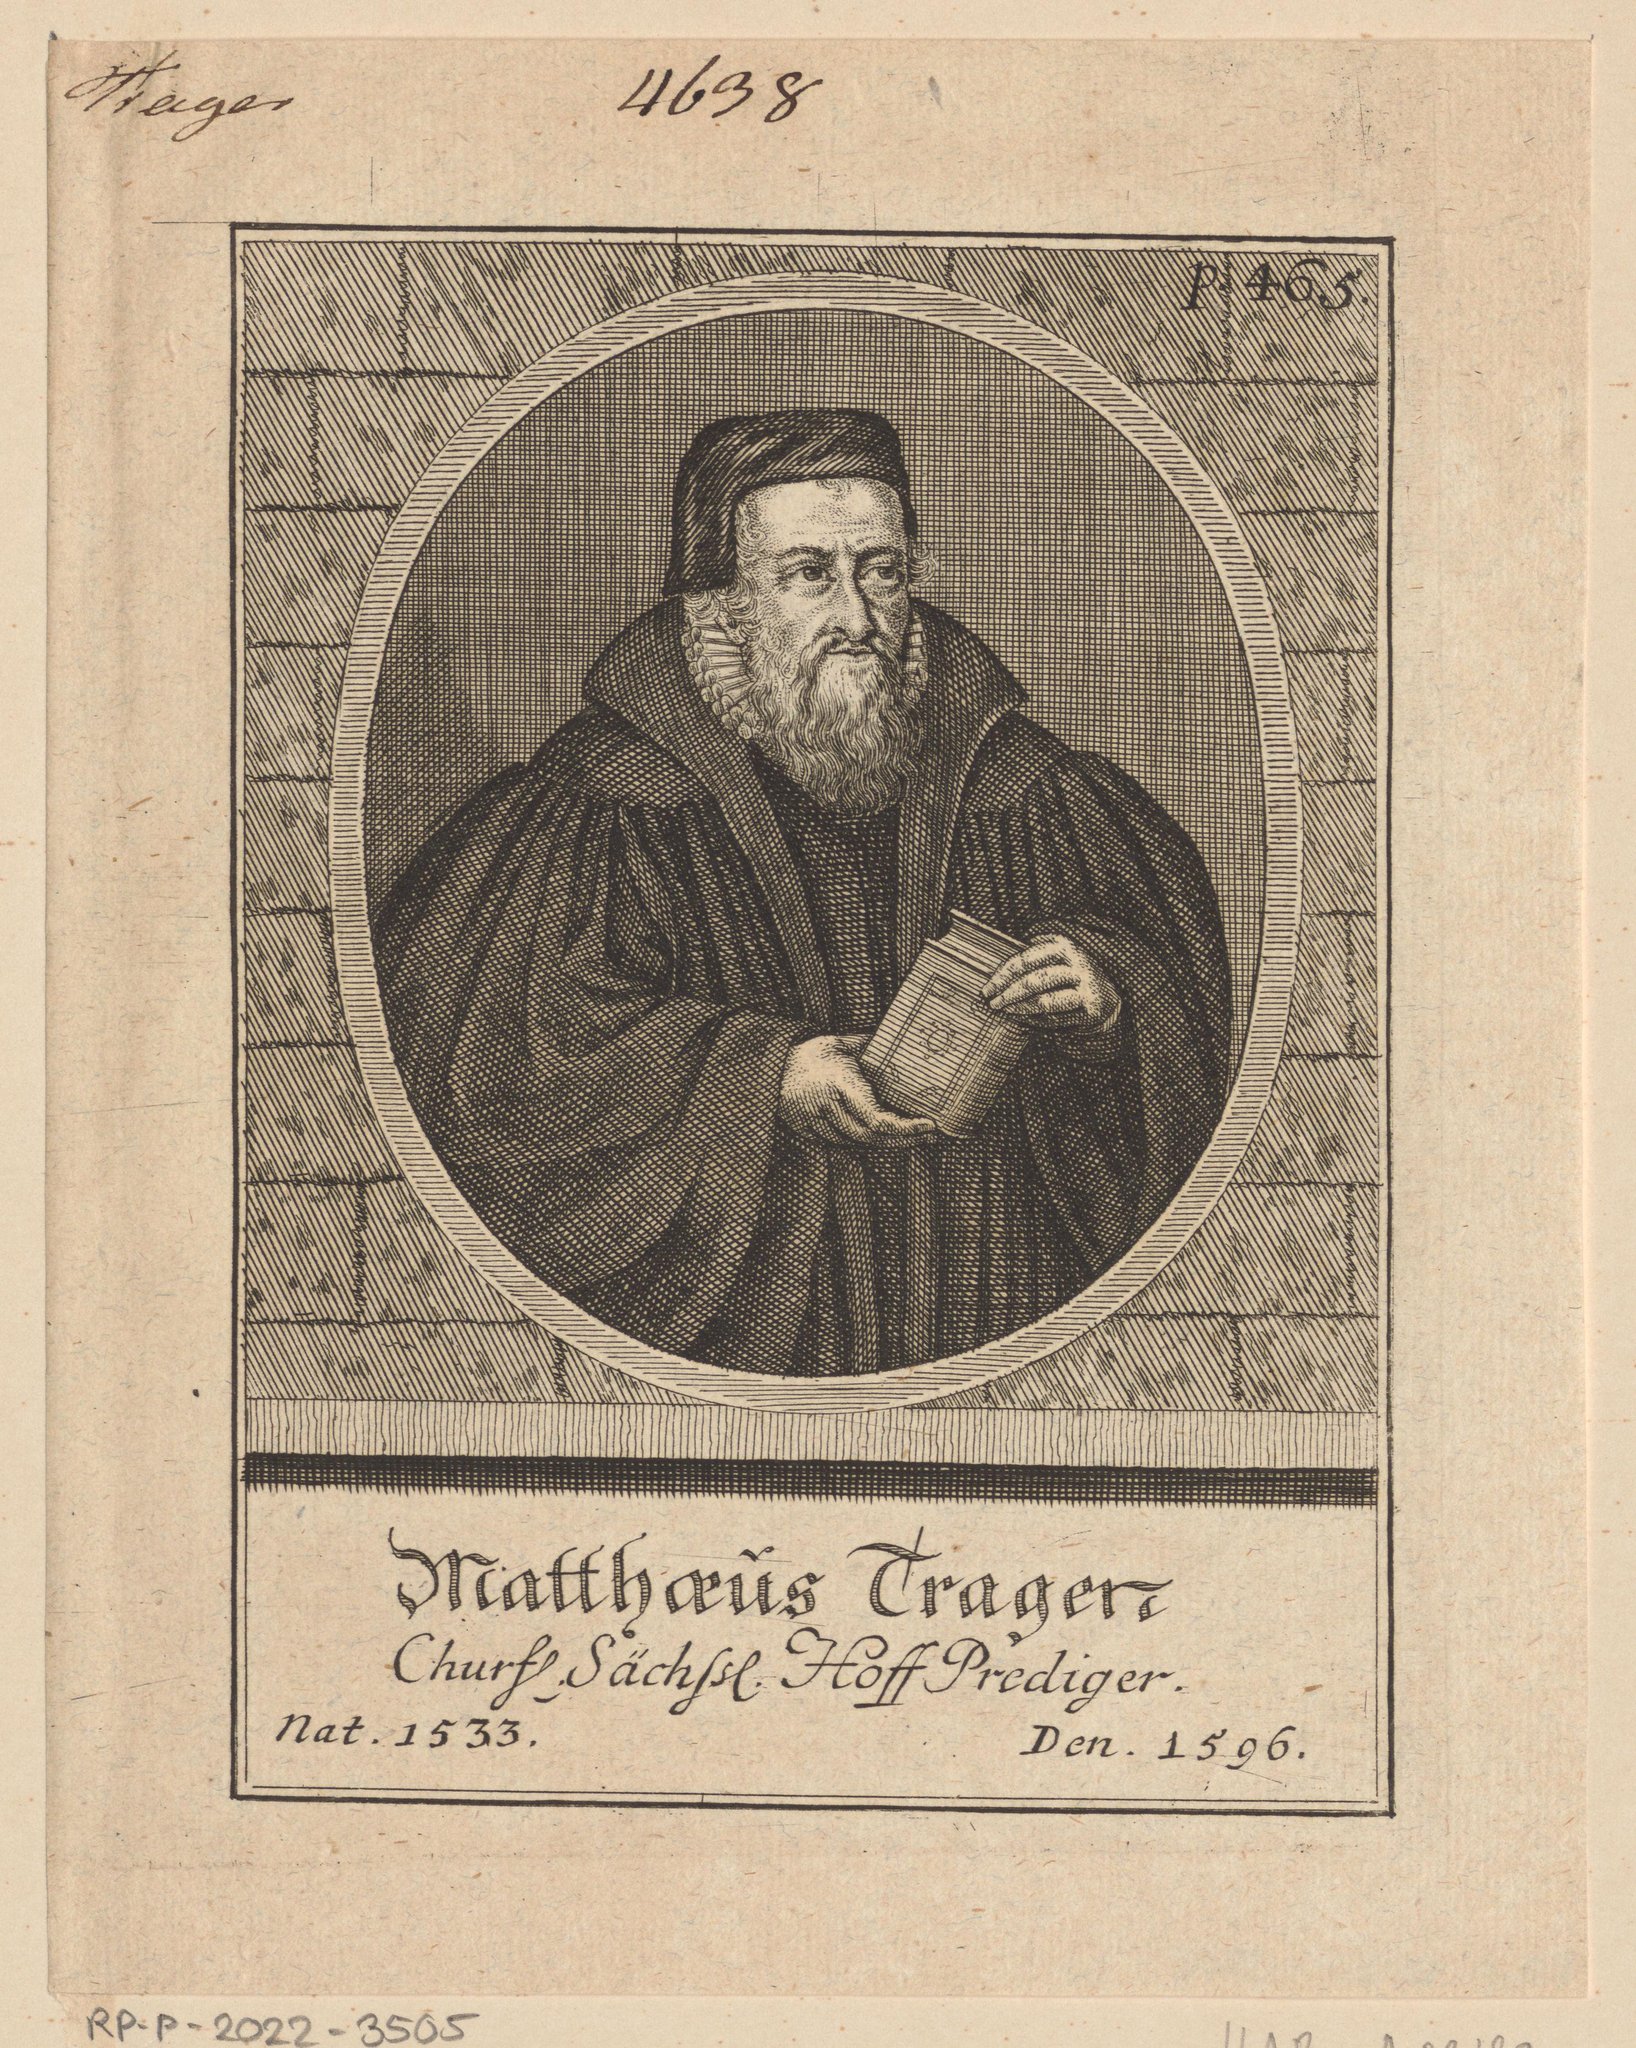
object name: print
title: Portret van Matthäus Tragen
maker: Anonymous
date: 1730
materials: paper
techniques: engraving, etching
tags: theologian, historical persons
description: Prent waarschijnlijk uit: Gleich, Johann Andreas. Annales ecclesiastici (...). Dresden en Leipzig: Raphael Christian Saueressig, 1730, dl 1, p. 464.